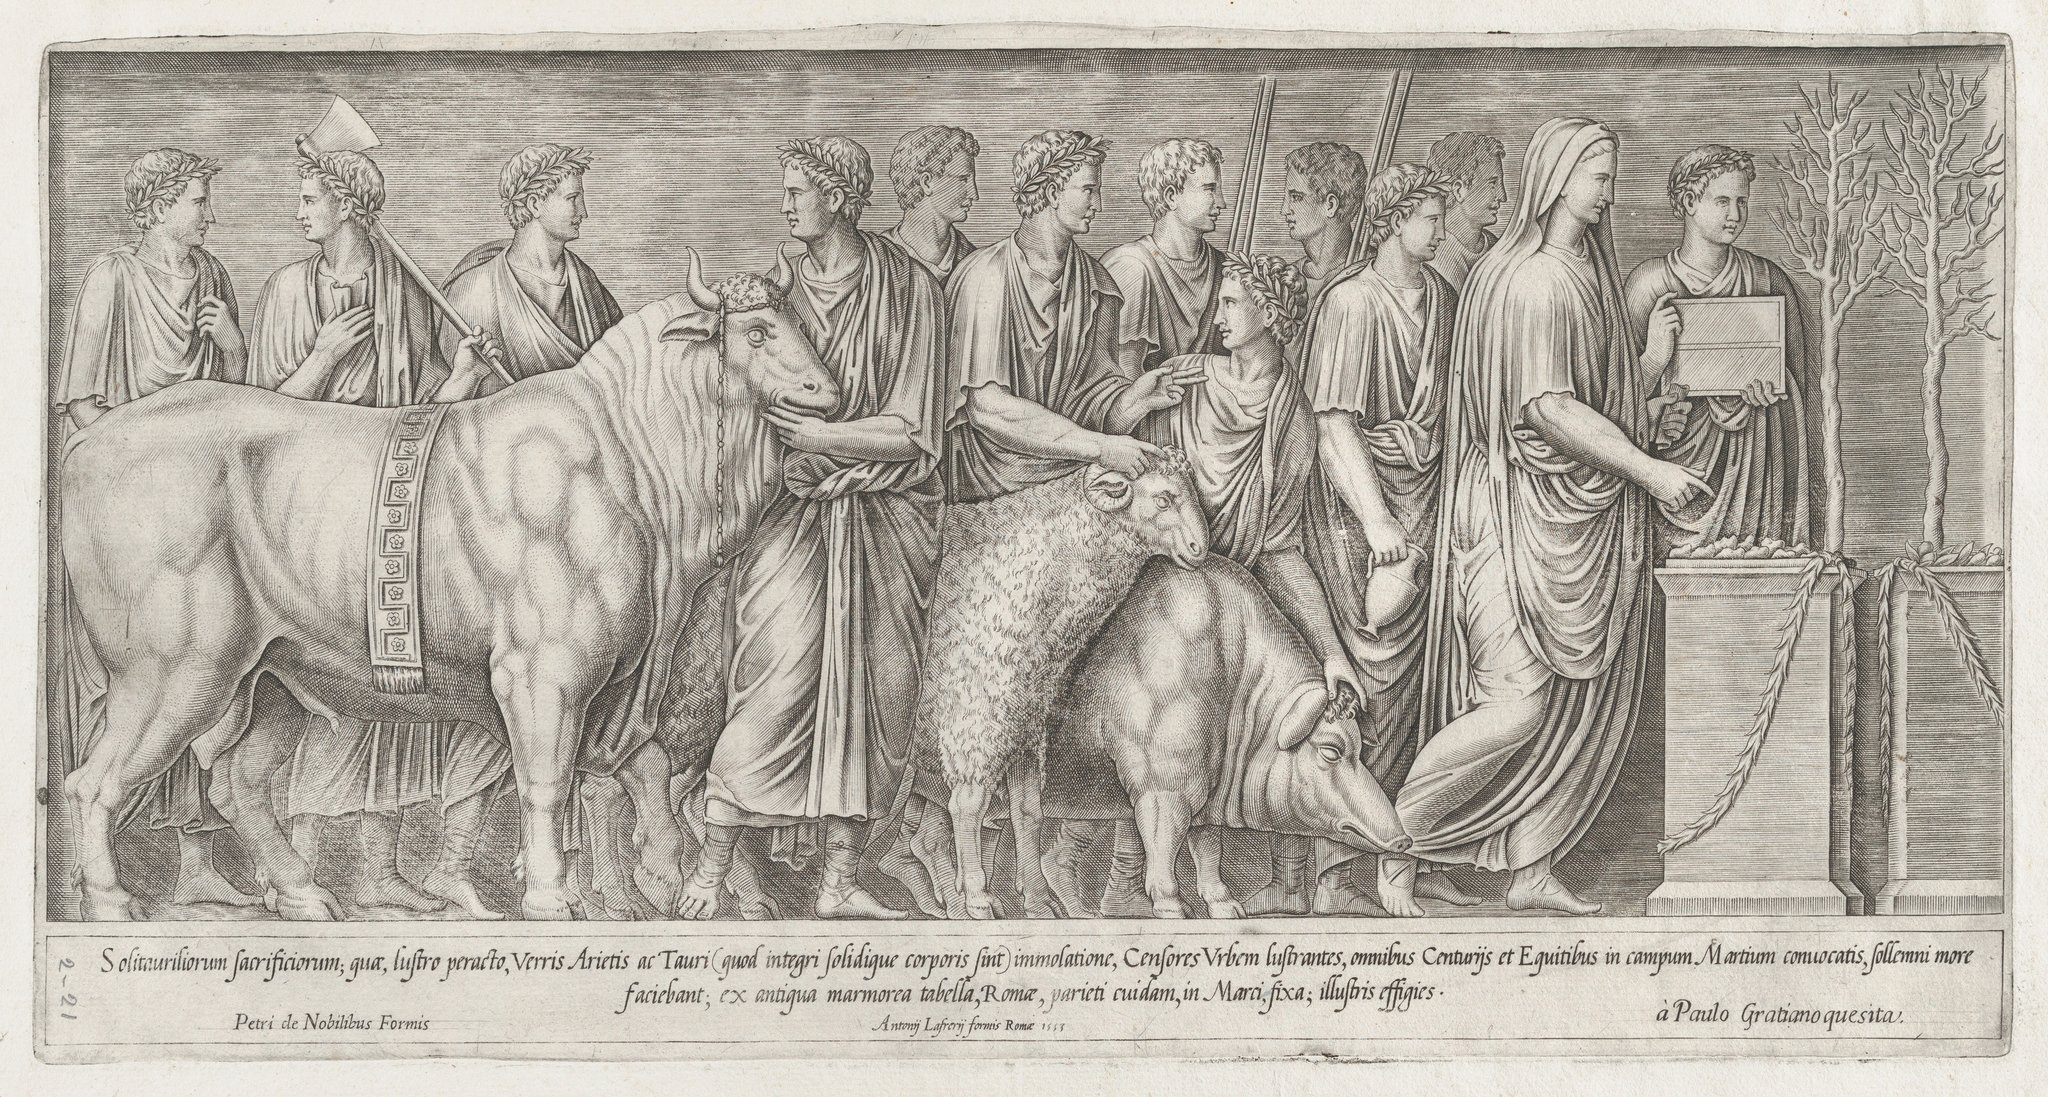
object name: print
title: Sacrifice on the Campus Martius, from "Speculum Romanae Magnificentiae"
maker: Anonymous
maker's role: artist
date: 1501-1600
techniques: engraving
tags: animals,men,women